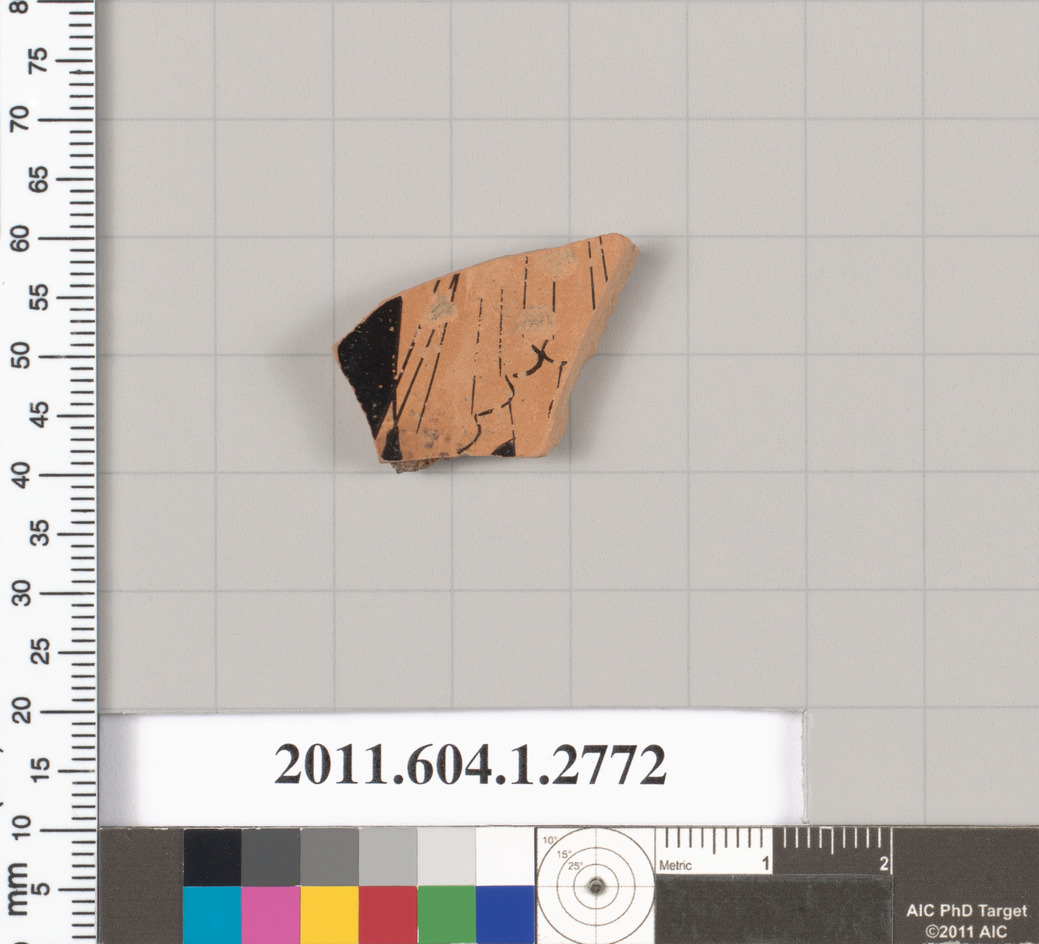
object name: kylix fragment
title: Terracotta fragment of a kylix (drinking cup)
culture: greek, attic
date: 475-451 BCE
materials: terracotta